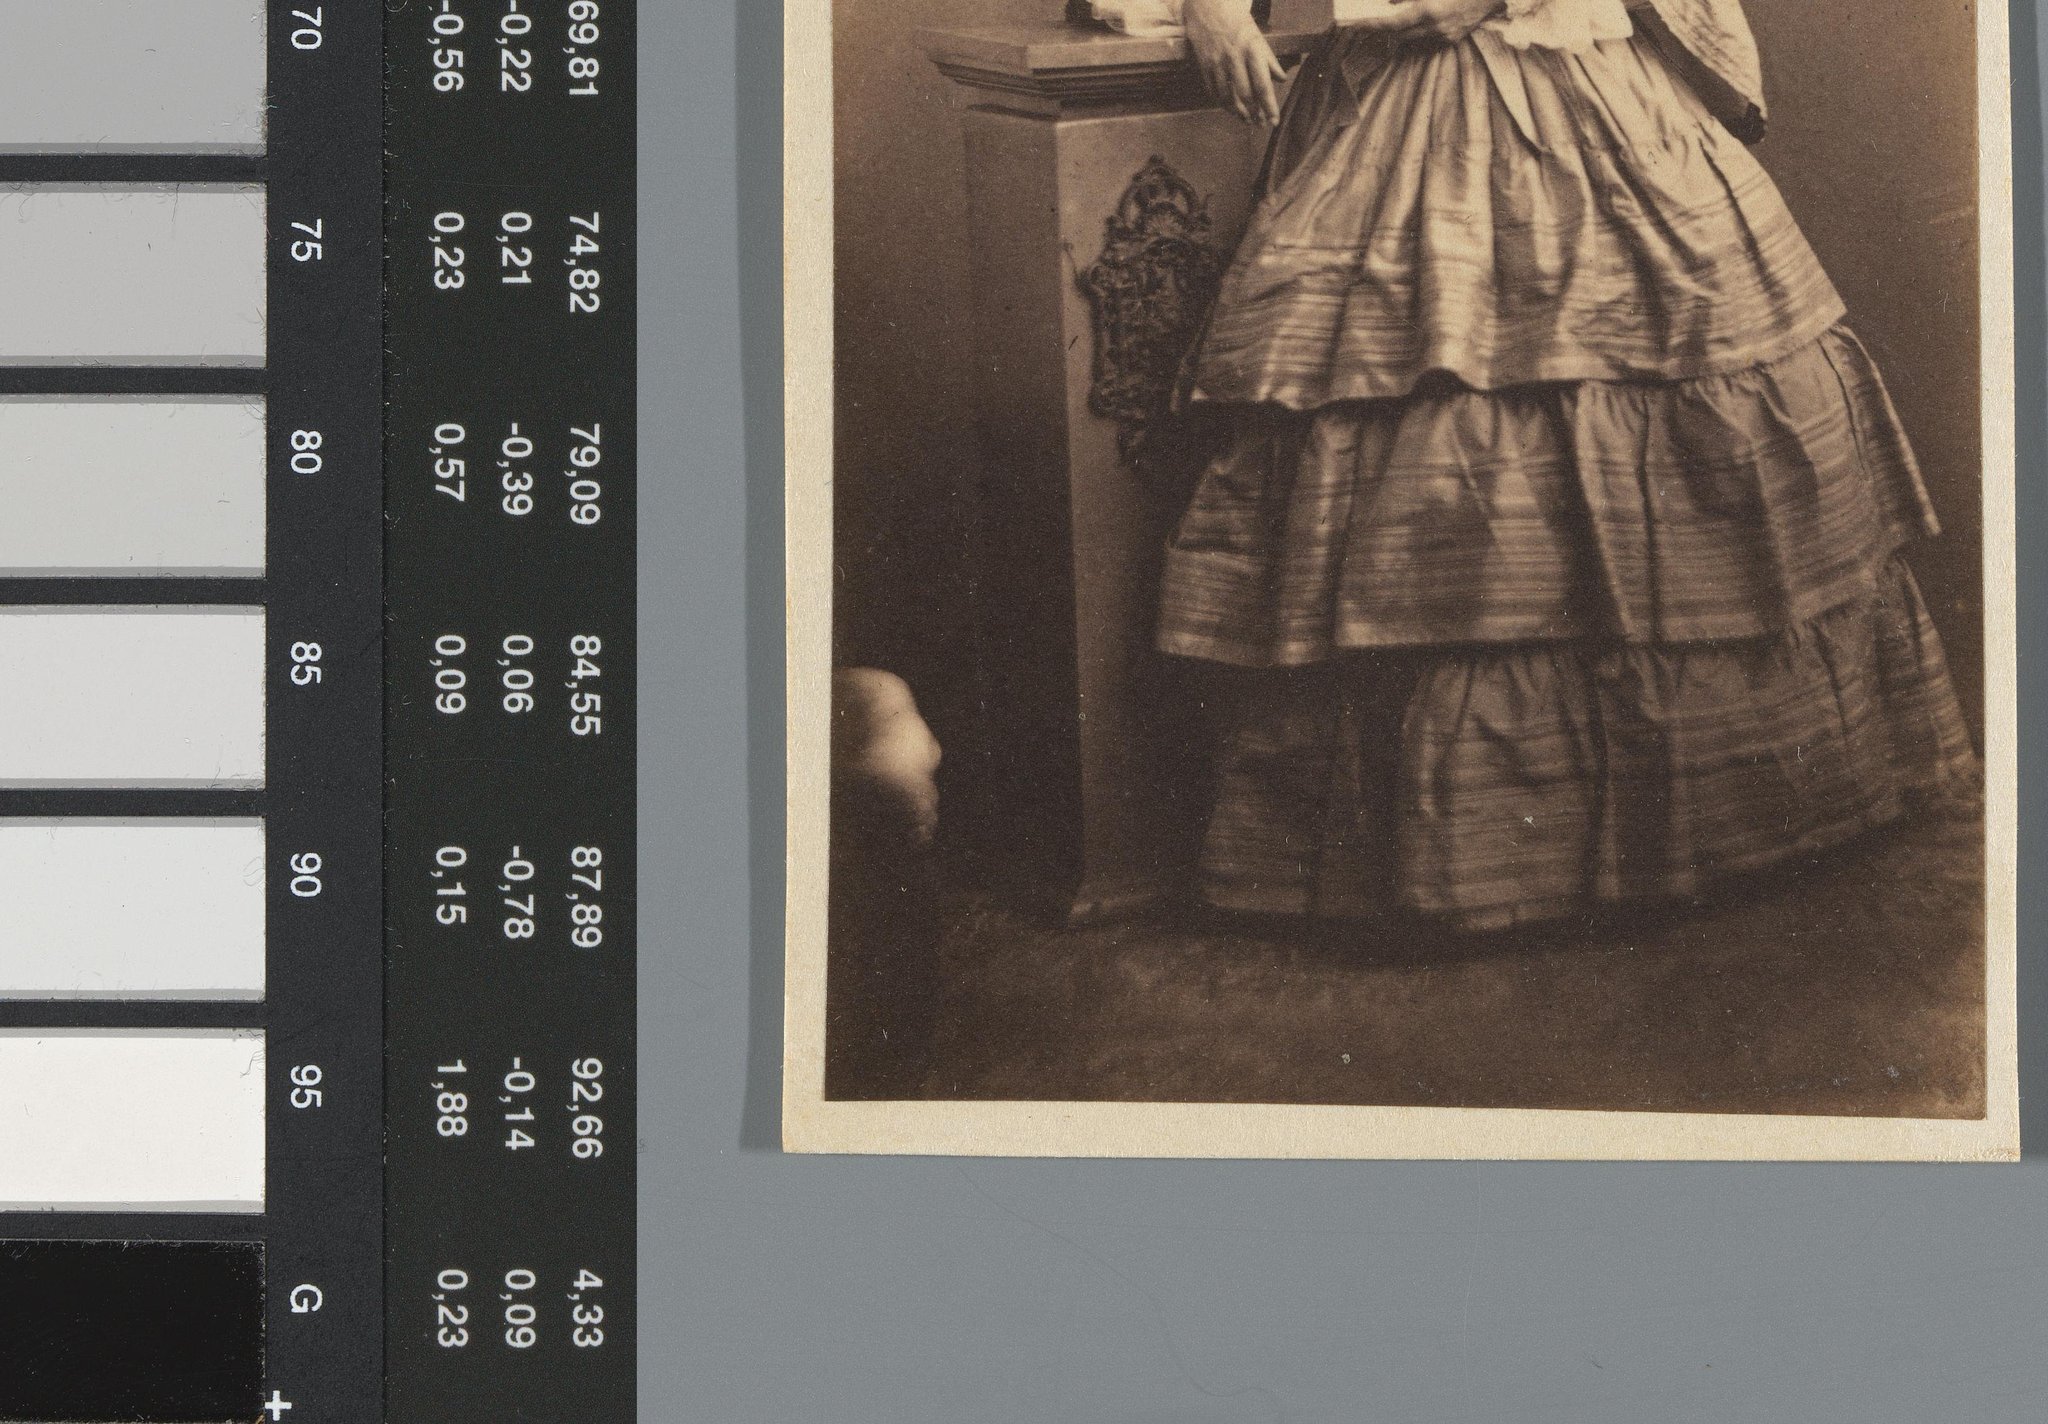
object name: carte de visite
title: Portret van Cornelia Theresia Carolina van den Berg (Cornelie)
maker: a. böeseken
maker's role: fotograaf, lithograaf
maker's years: 1834-1919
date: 1855-1910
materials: cardboard, photographic support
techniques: albumen print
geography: rotterdam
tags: rotterdam, delft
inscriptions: inscription: ‘Cornelie / van den Berg / 1837 -1907’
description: Staande vrouw ten voeten uit met een brief in de hand leunend op een sokkel.